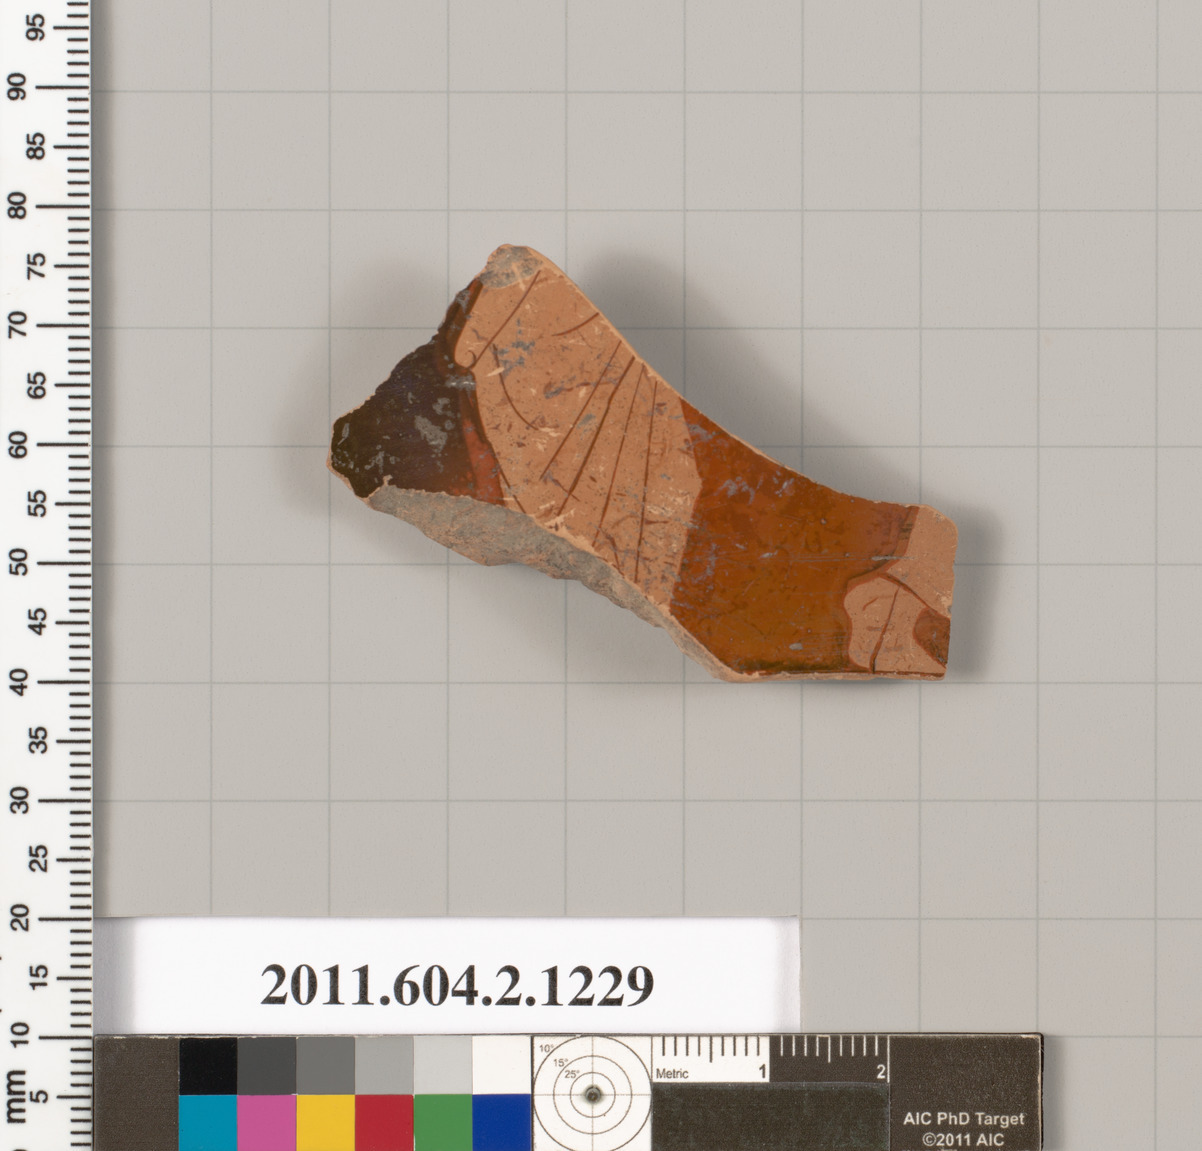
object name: rhyton fragment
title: Terracotta rhyton (vase for libations or drinking)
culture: greek, attic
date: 475-451 BCE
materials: terracotta